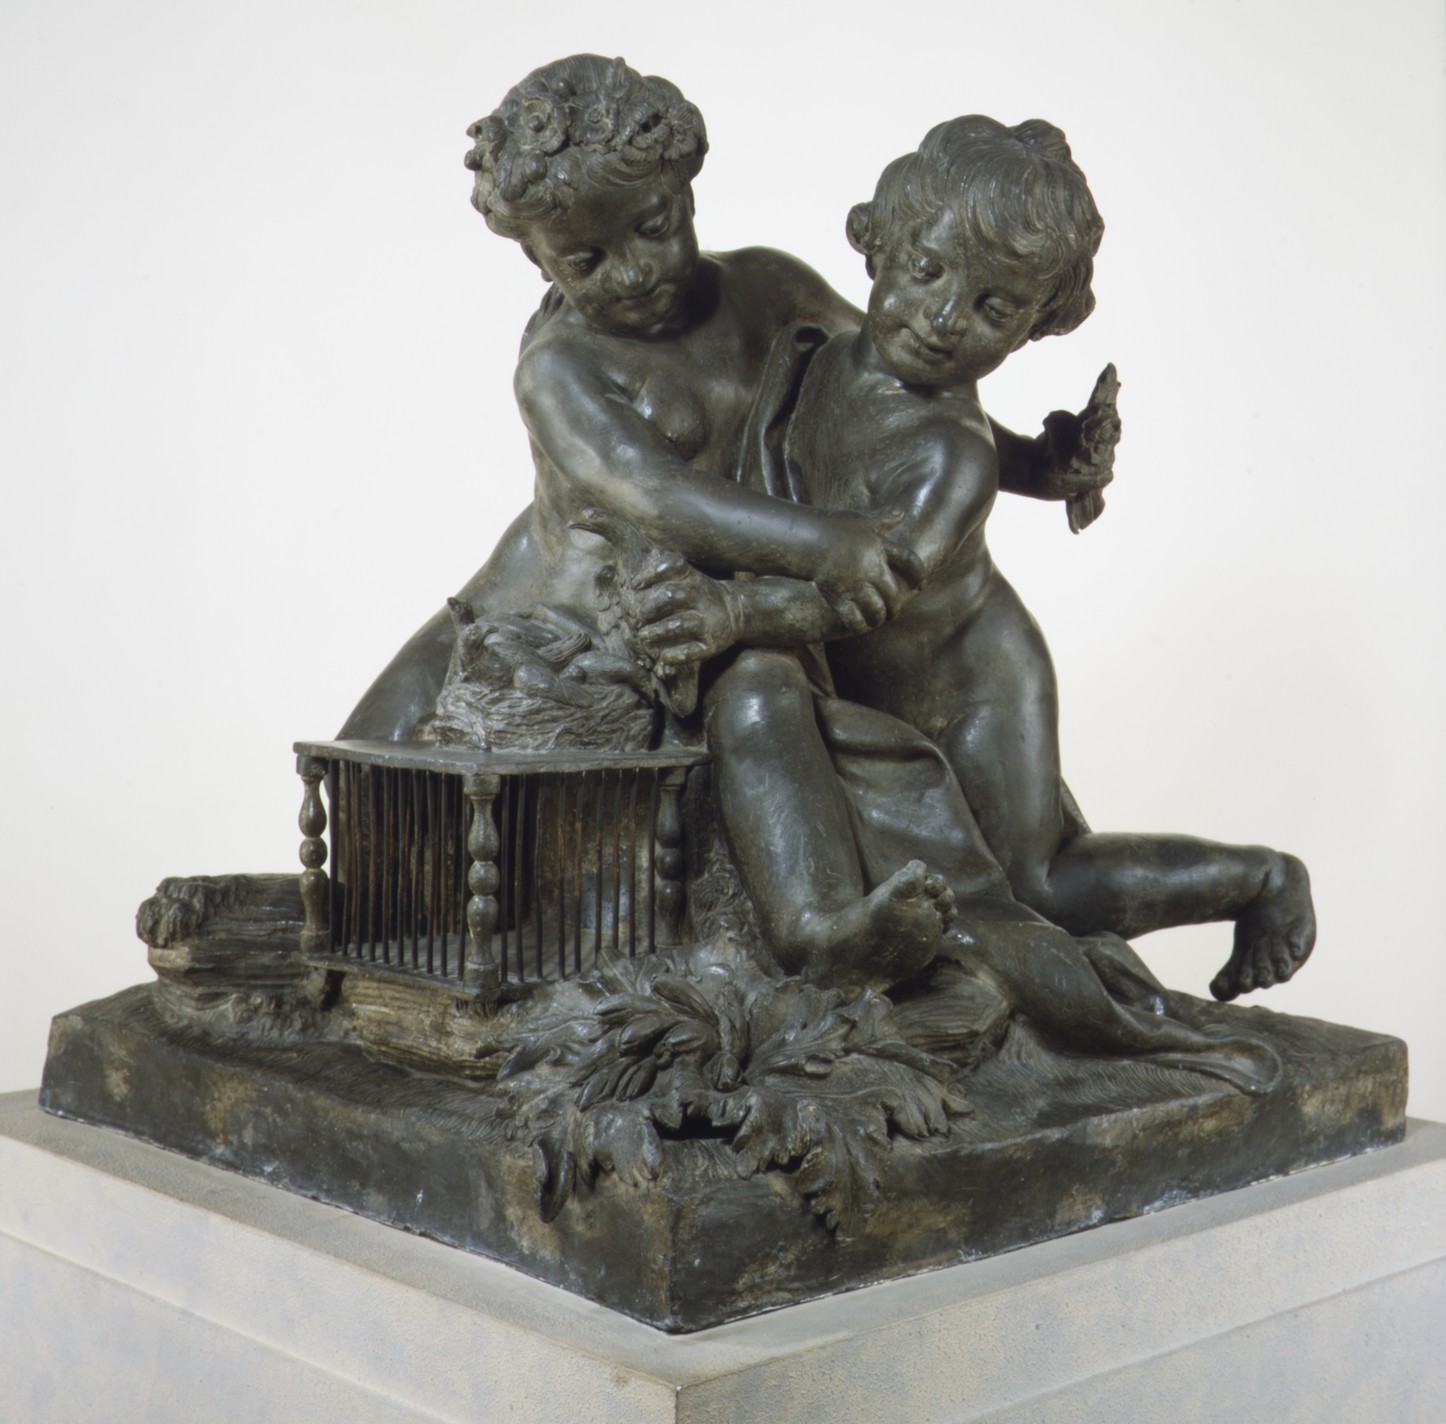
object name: group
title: Children playing with birds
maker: francesco ladatte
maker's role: artist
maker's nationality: italian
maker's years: 1706-1787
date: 1745-1750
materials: lead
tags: birds,boys,girls,playing